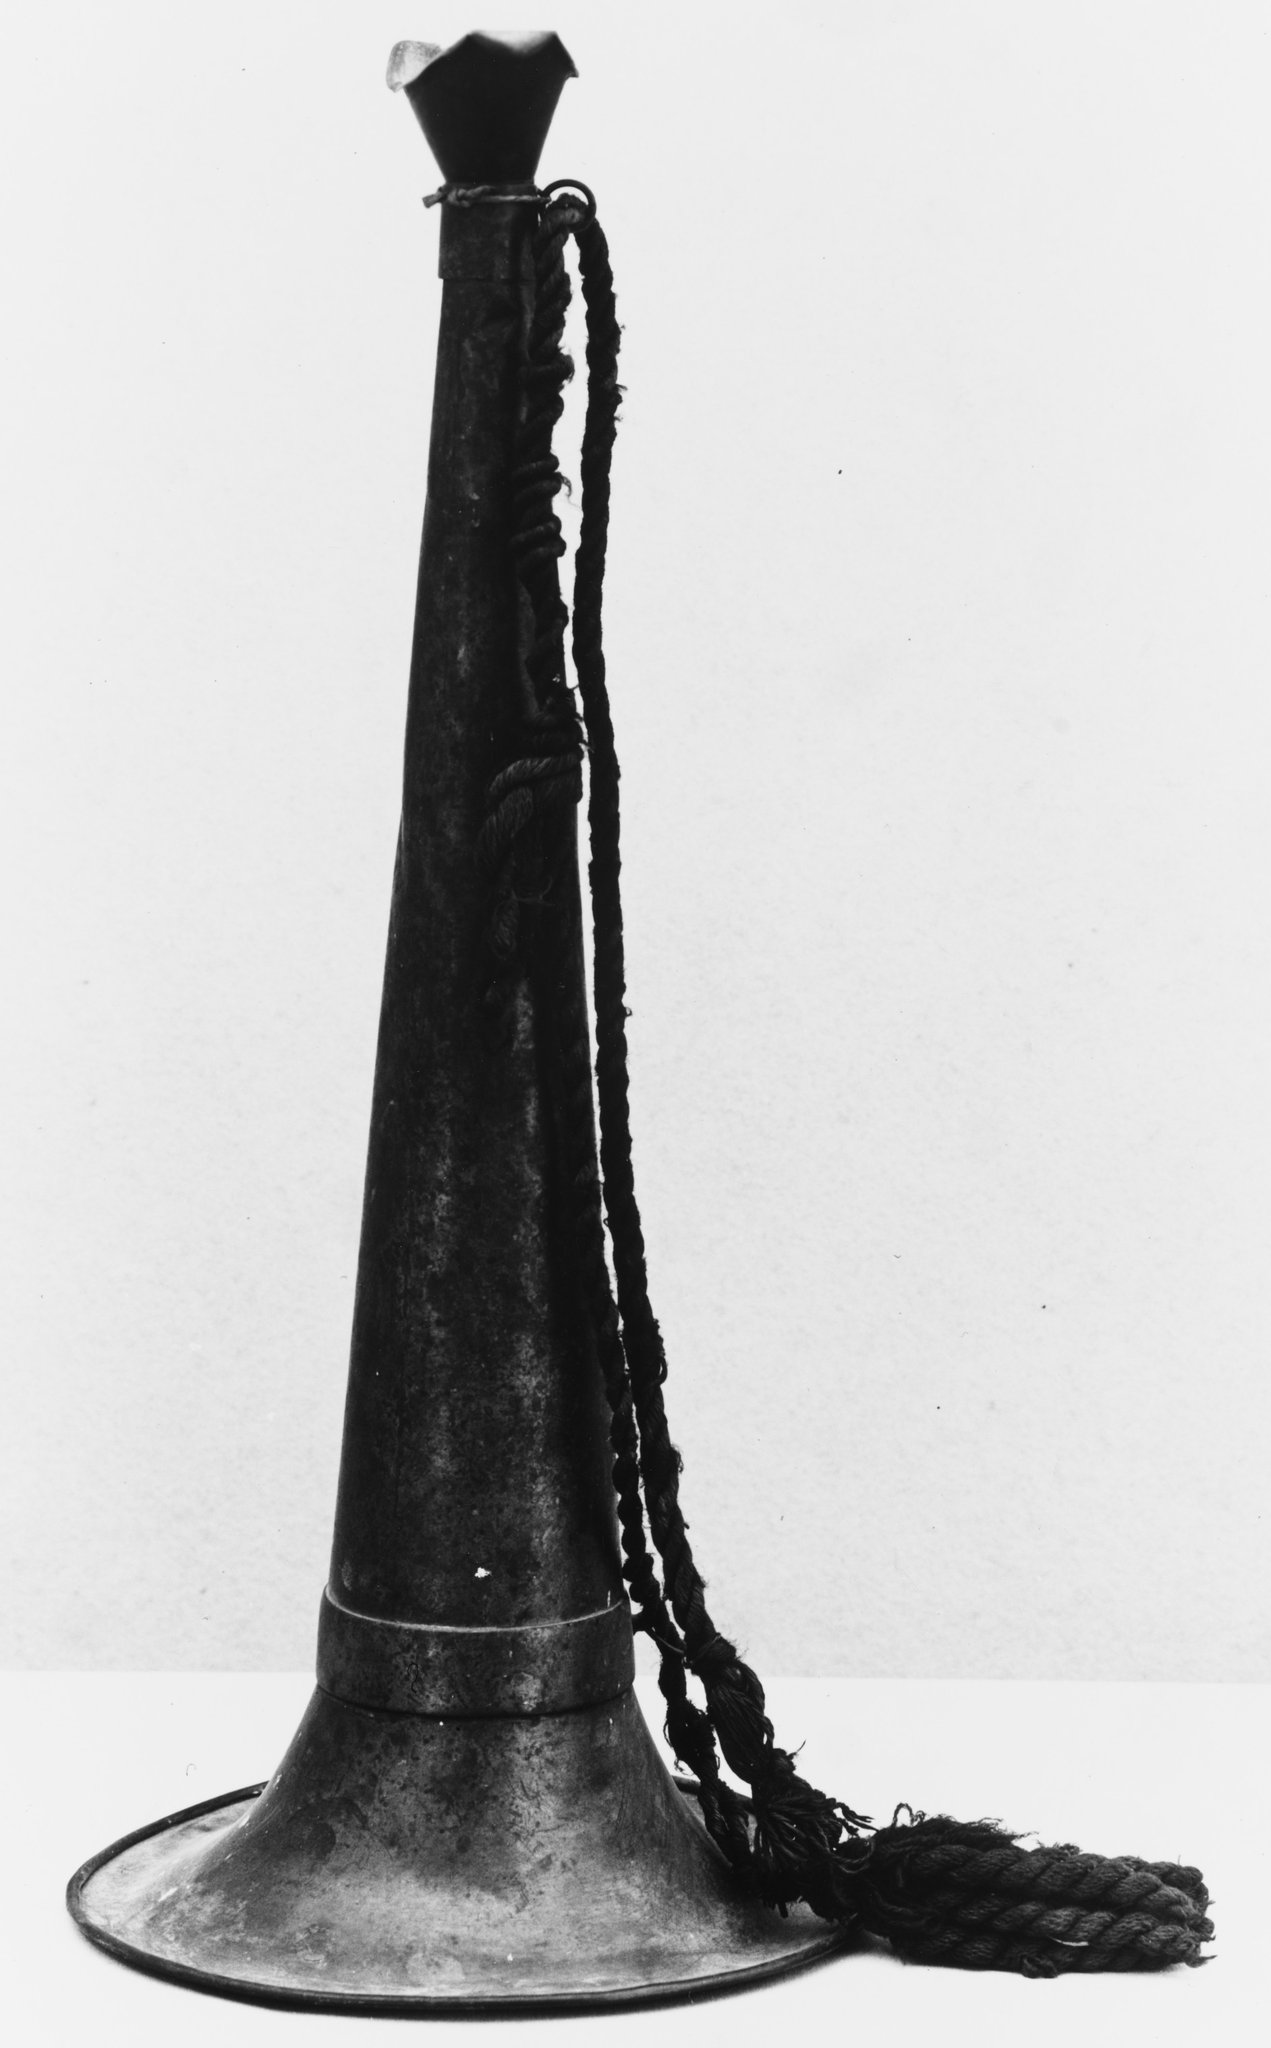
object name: fireman's trumpet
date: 1800-1850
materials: brass, silk